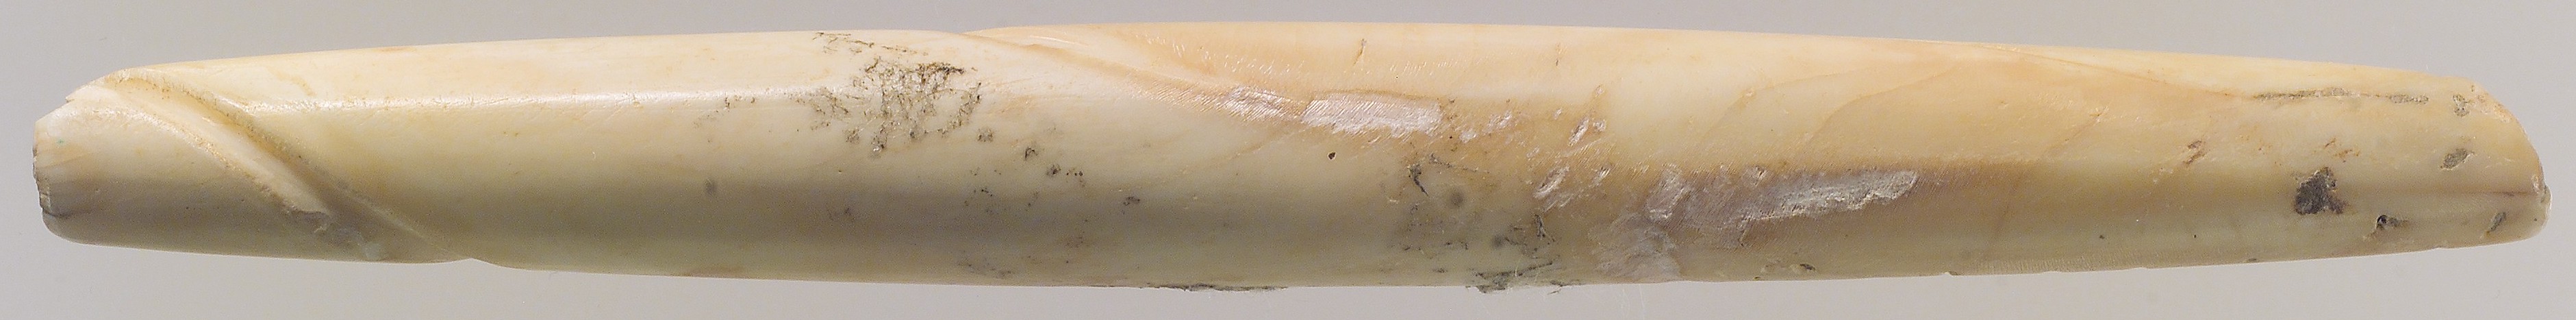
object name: bead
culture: sumerian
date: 2900-2350 BCE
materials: shell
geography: mesopotamia